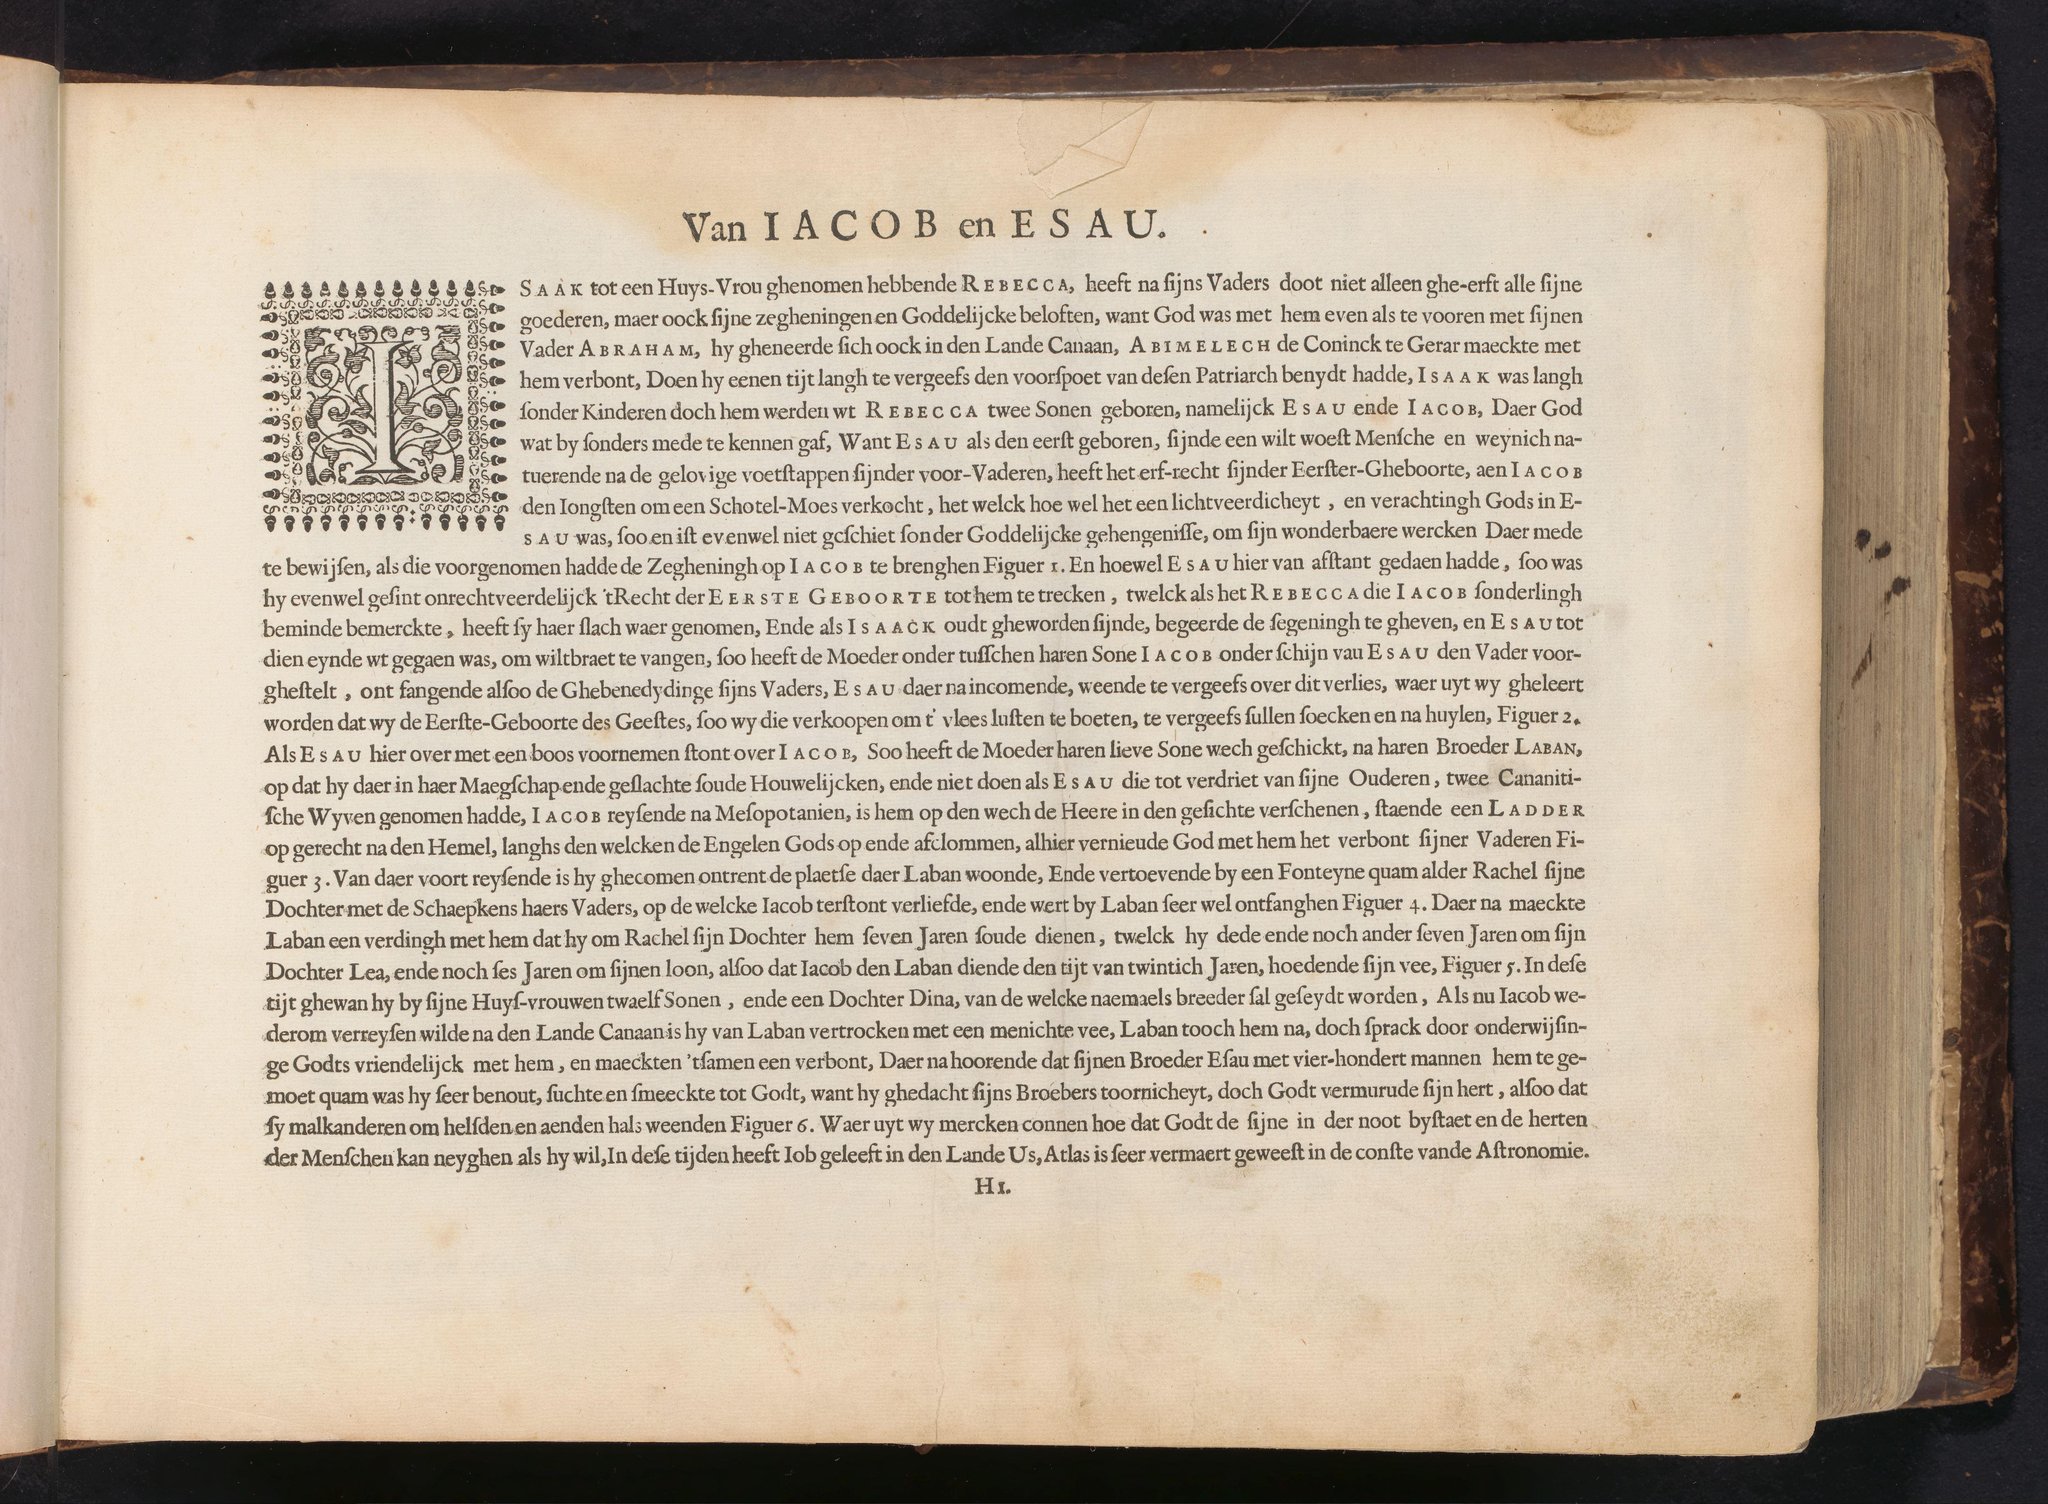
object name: text sheet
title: Den Grooten Figuer-Bibel (...)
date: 1646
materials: paper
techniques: letterpress printing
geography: alkmaar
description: Tekstblad bij een serie prenten over de geschiedenis van Jakob en Esau. Dit blad maakt deel uit van een album.